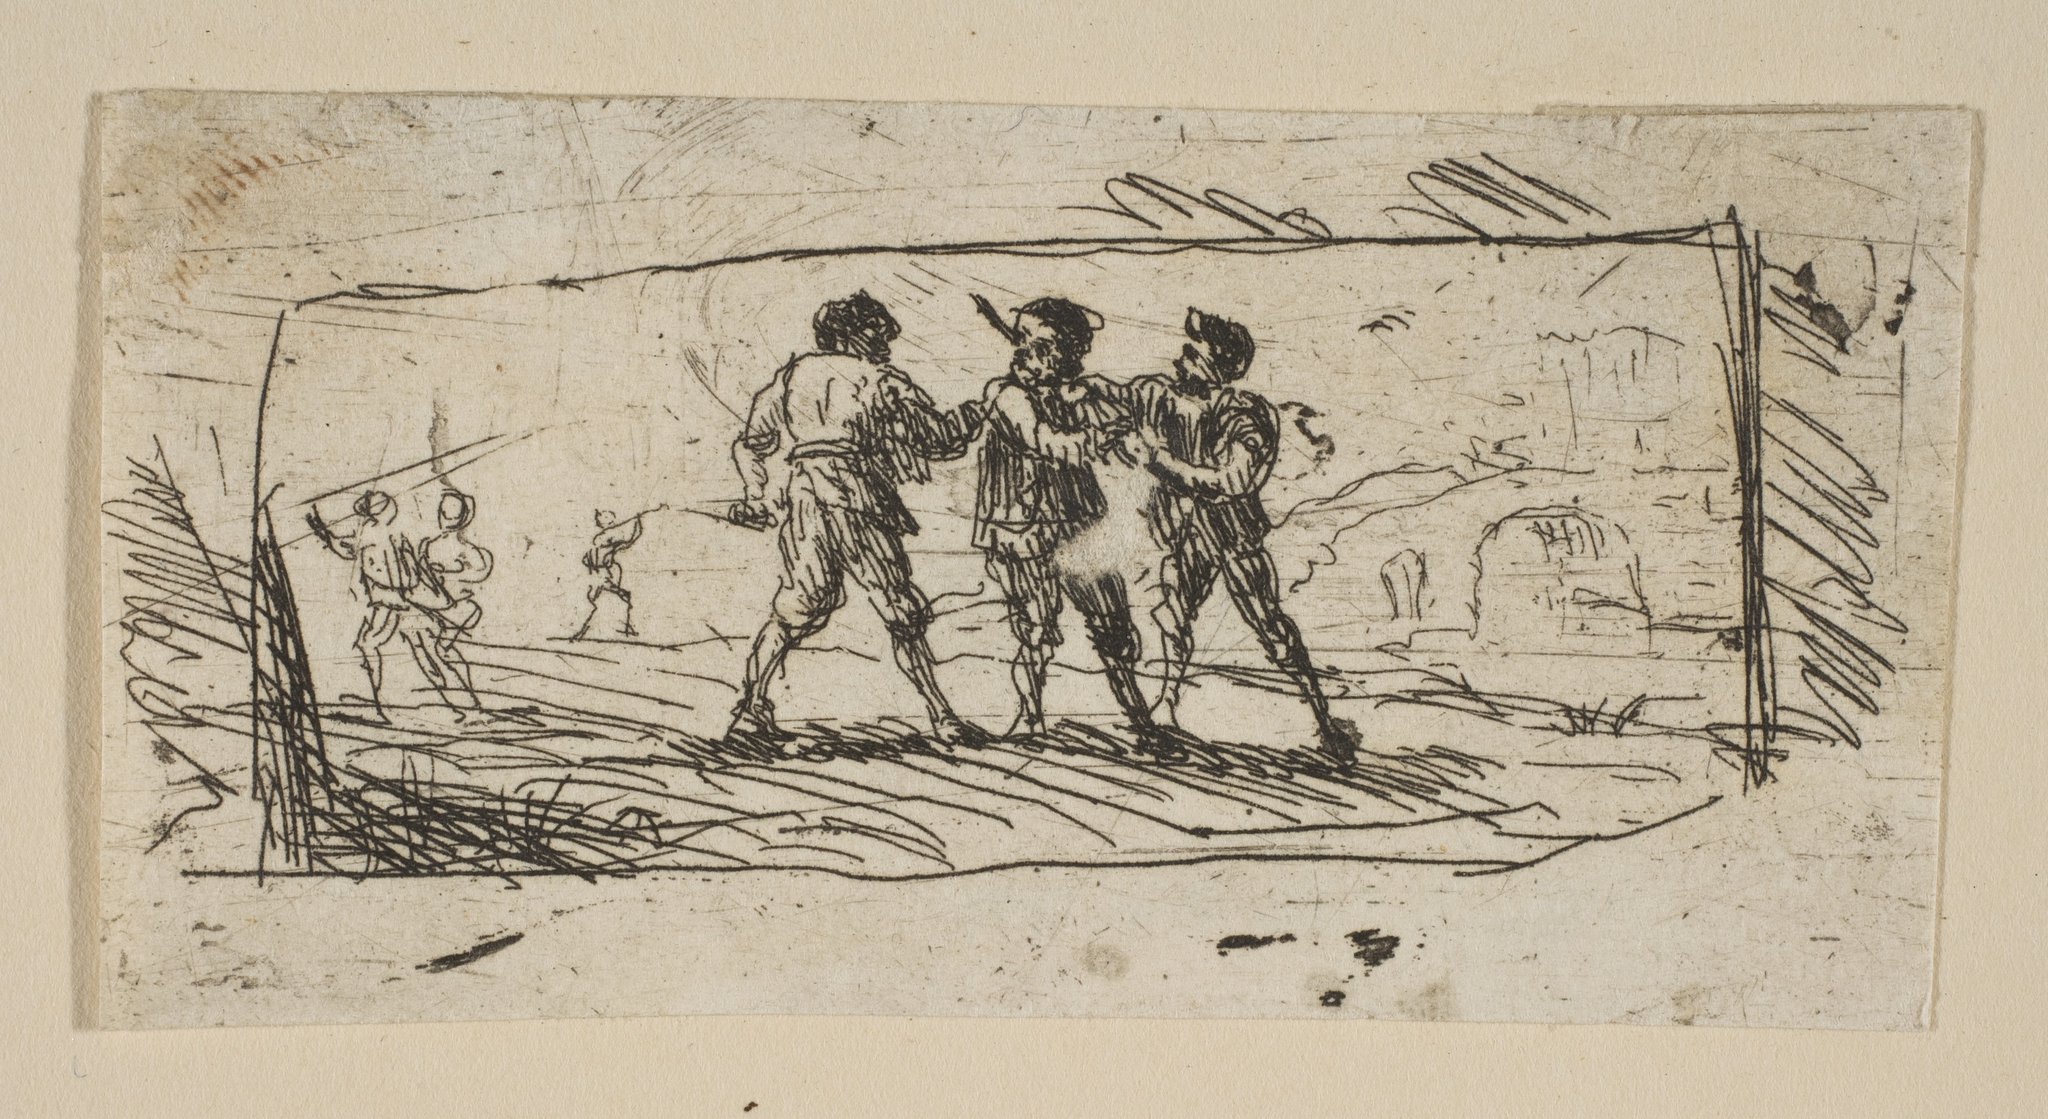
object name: print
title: Study with Brigands (Lower Section)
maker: claude lorrain (claude gellée)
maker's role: artist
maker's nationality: french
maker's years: 1604-1682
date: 1633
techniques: etching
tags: men